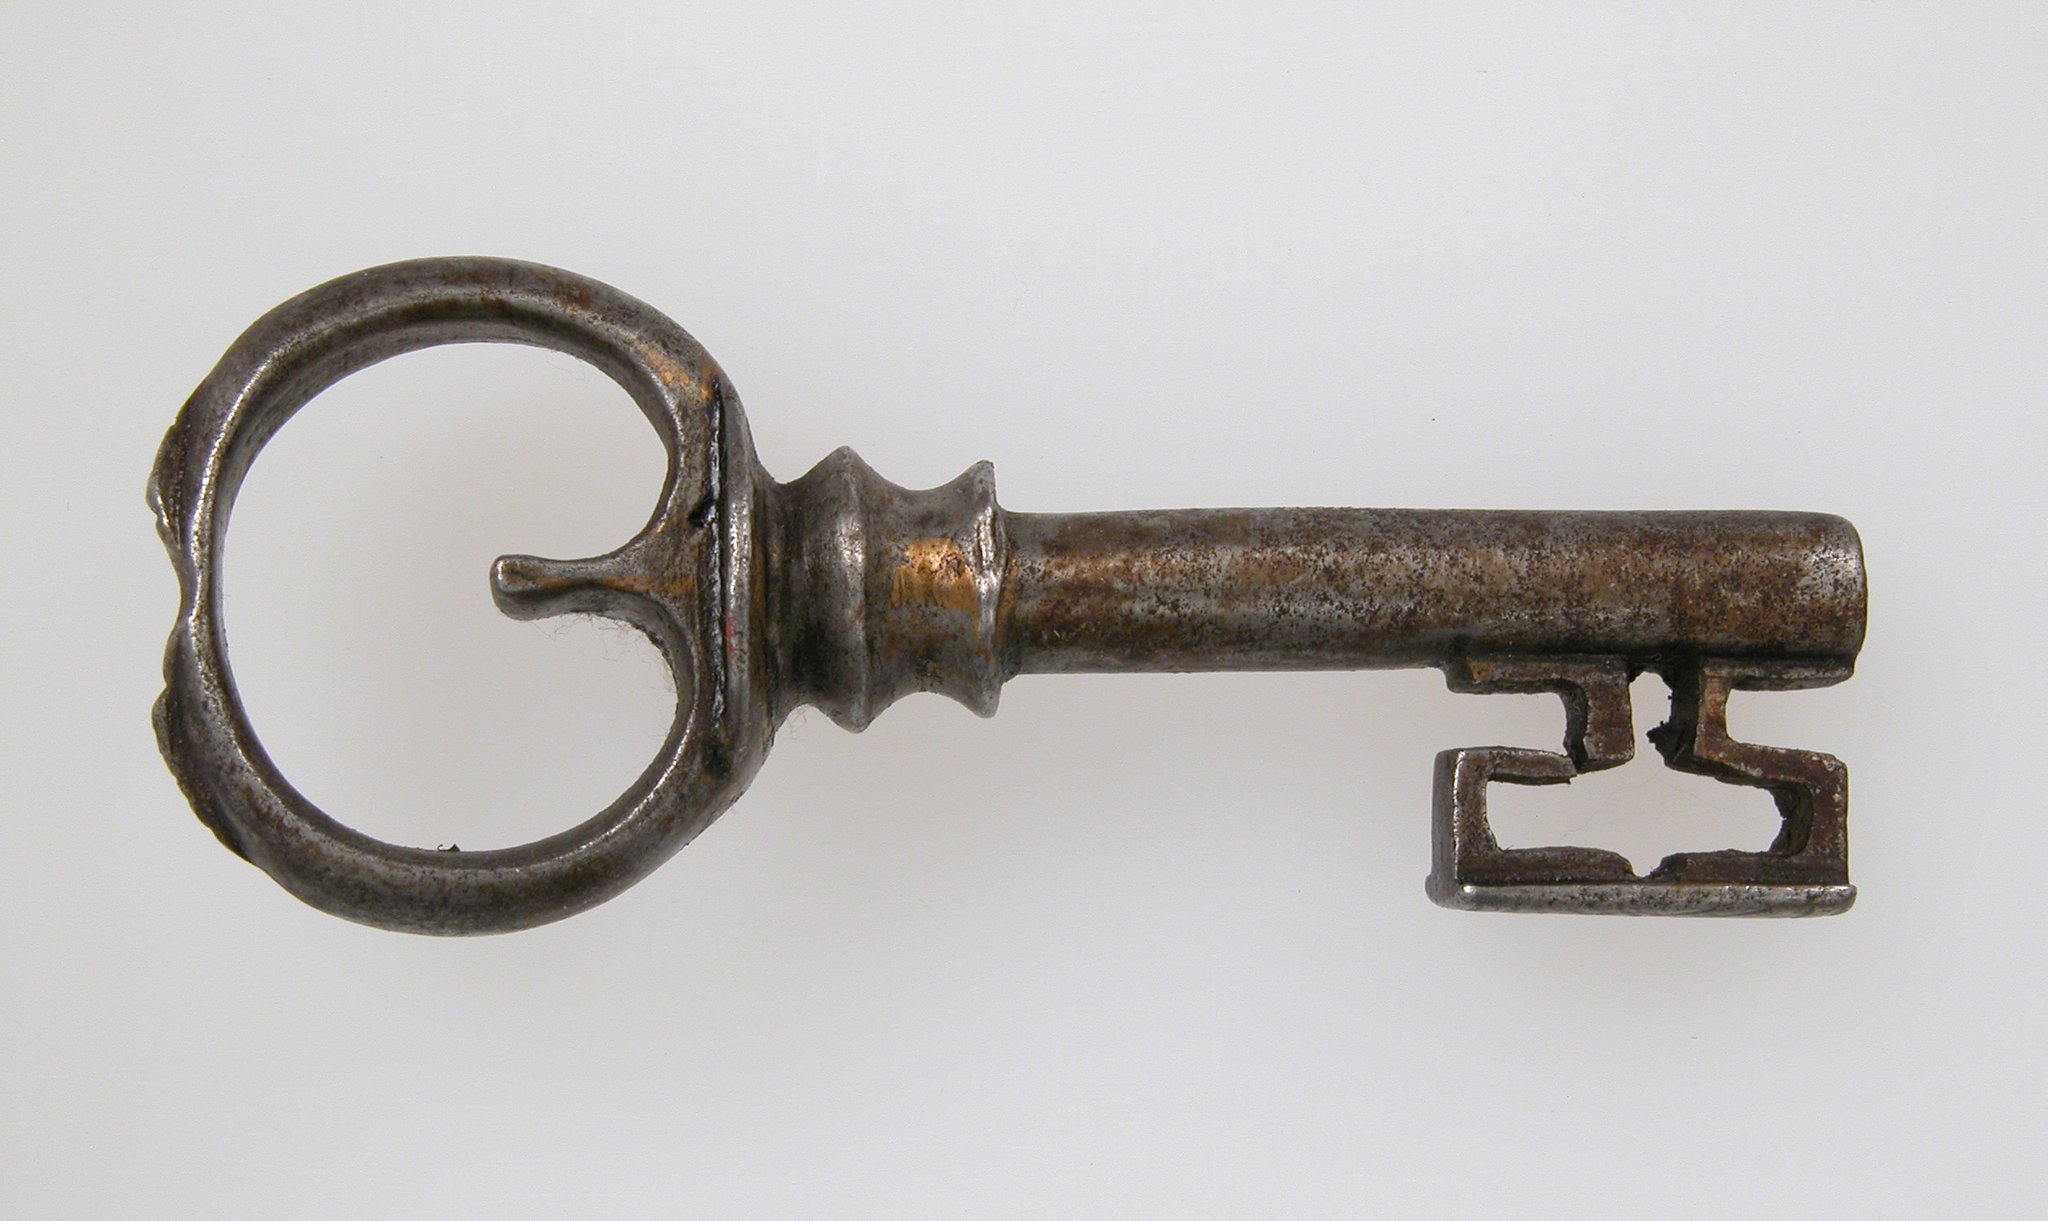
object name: key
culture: german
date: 1401-1500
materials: iron